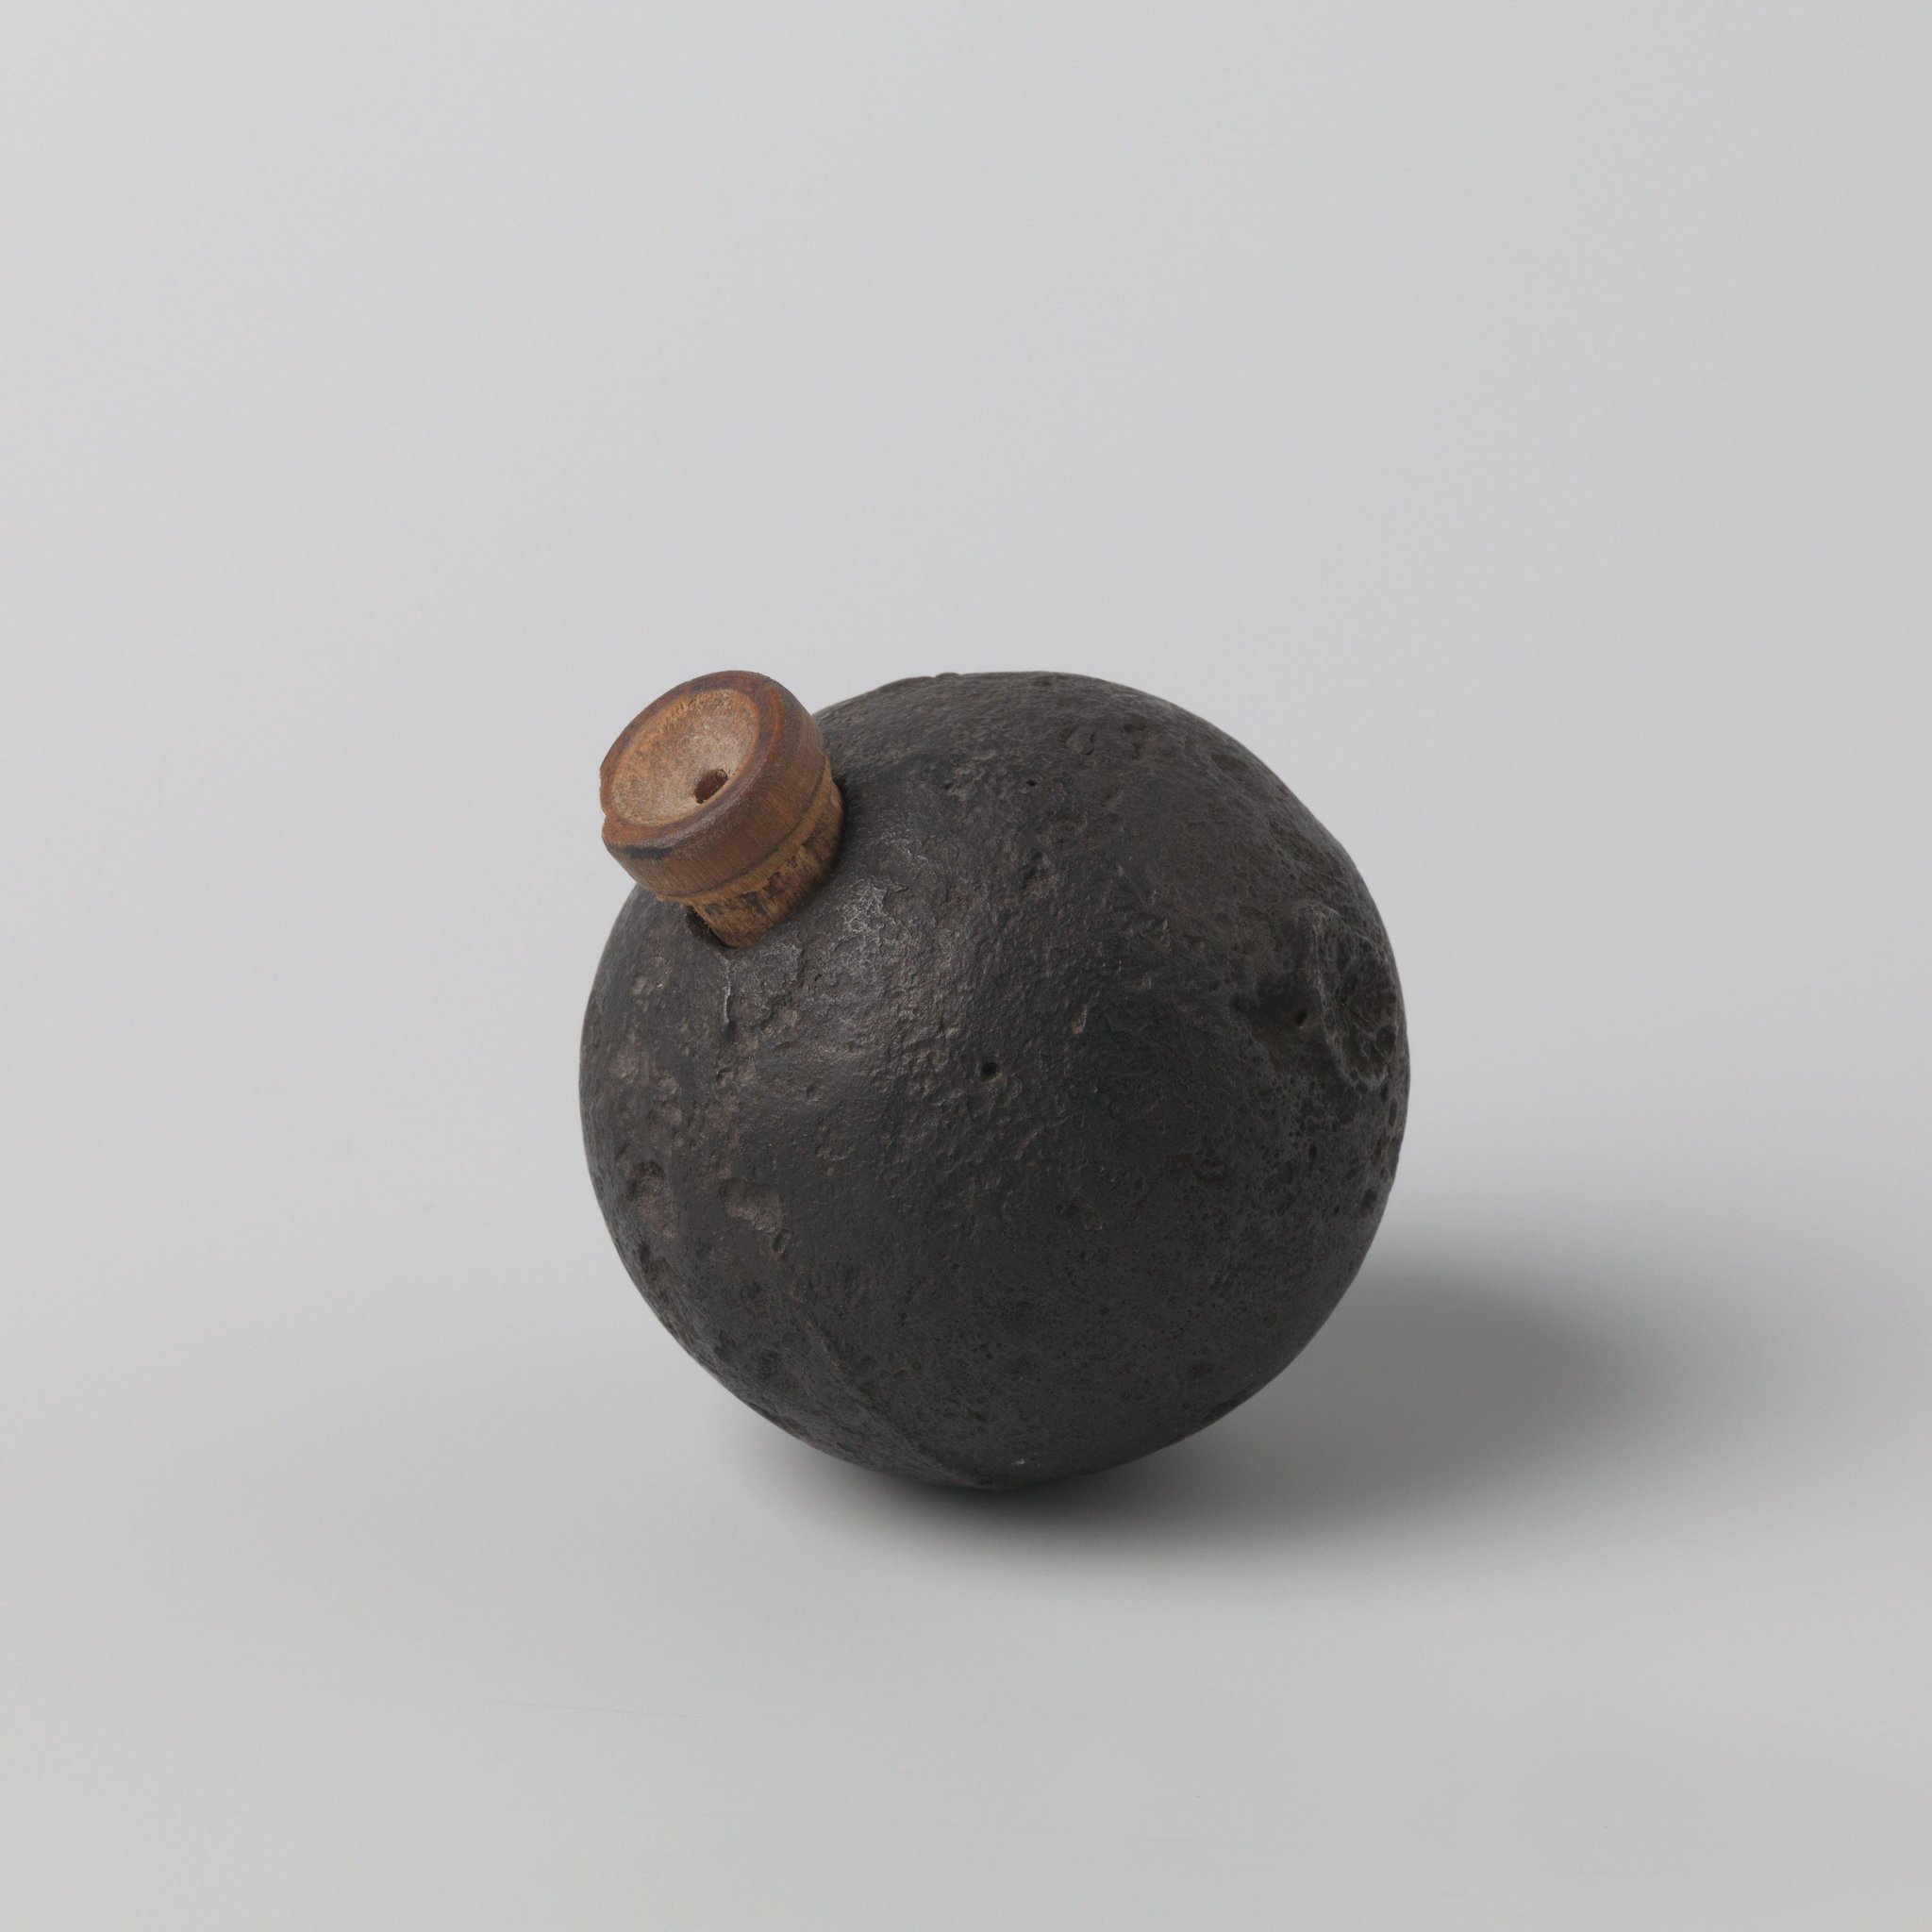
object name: grenade ammunition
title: Granaat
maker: Anonymous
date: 1599-1899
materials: iron, wood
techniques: casting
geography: netherlands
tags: loevestein castle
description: Model van een handgranaat voorzien van een replica tijdbuis in de vorm van een houten stop. Duidelijke gietnaad op de bom.